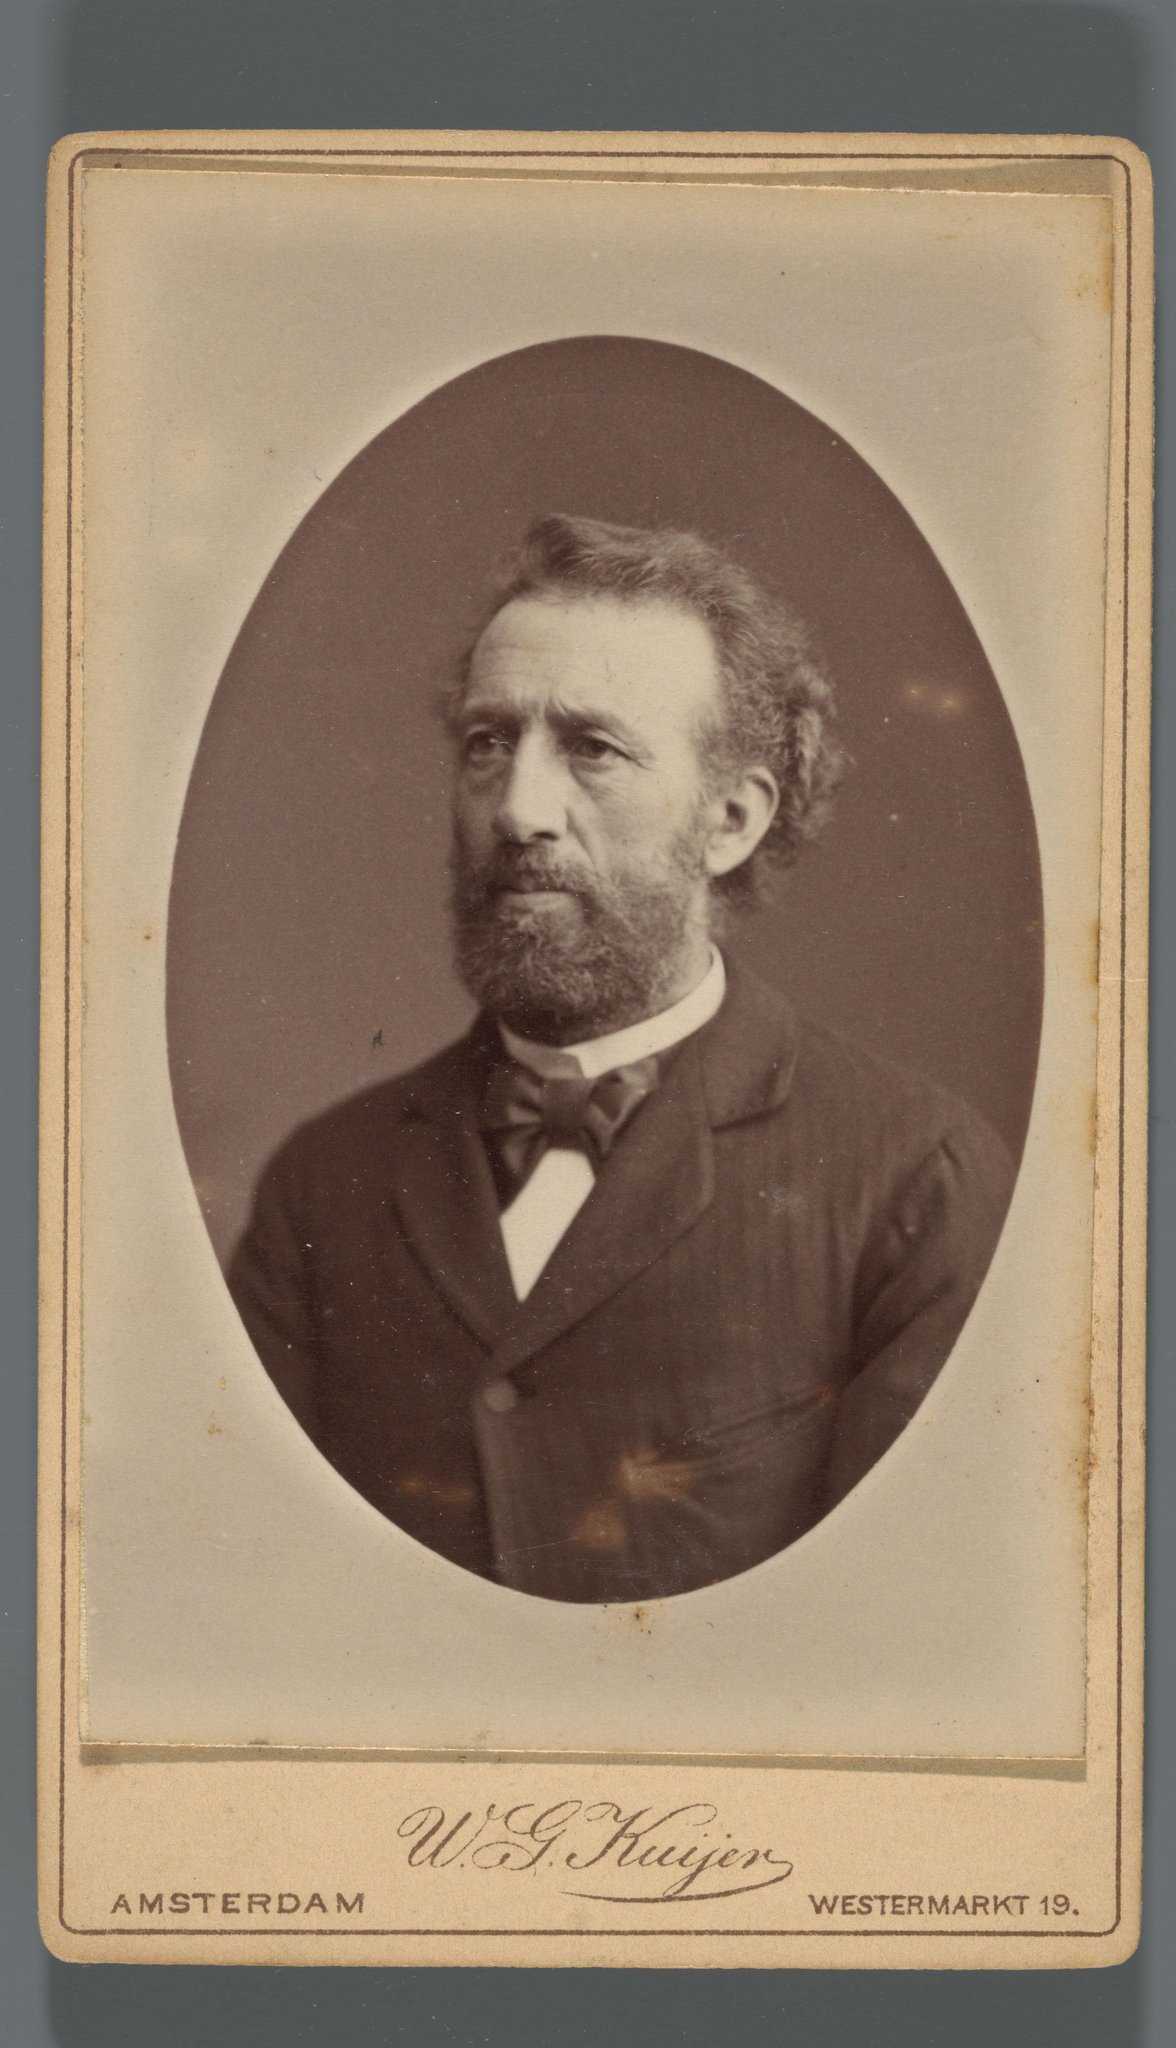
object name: carte de visite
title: Portret van een man uit de familie Marmelstein, vermoedelijk de vader van A. F. Marmelstein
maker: willem gerhardus kuijer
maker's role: fotograaf, hoffotograaf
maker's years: 1834-1899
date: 1850-1900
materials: cardboard, photographic support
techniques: albumen print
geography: amsterdam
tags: adult man, historical persons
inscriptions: retailer's mark: ‘W.G. Kuijer/ Westermarkt 19/ Amsterdam/ 5’